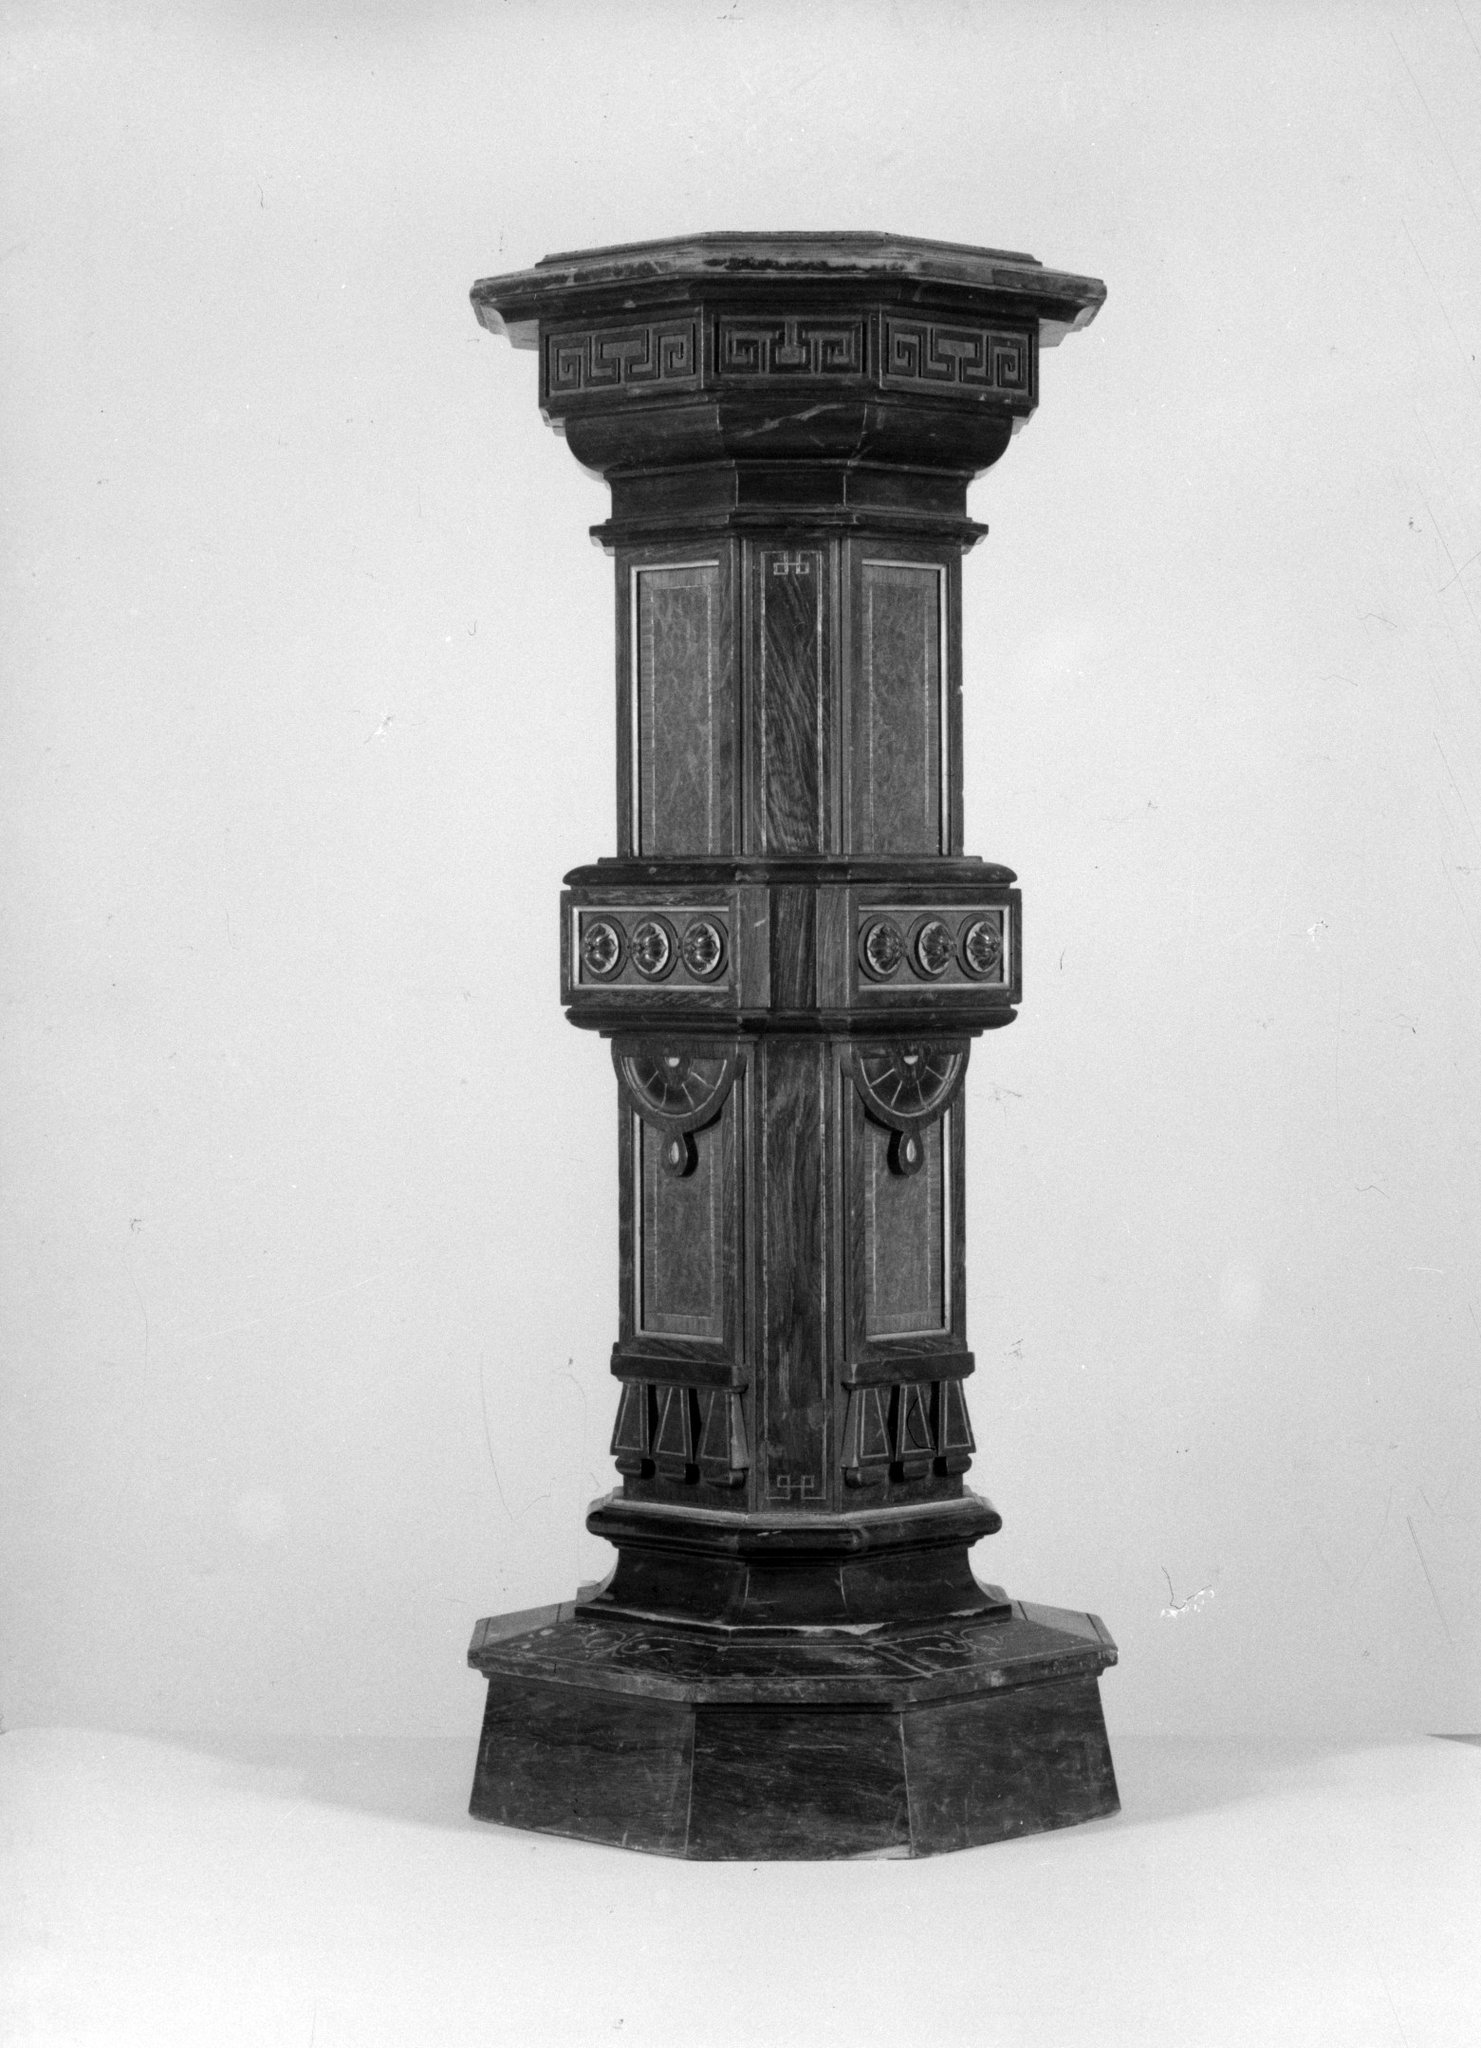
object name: pedestal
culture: american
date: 1870-1875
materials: wood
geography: united states